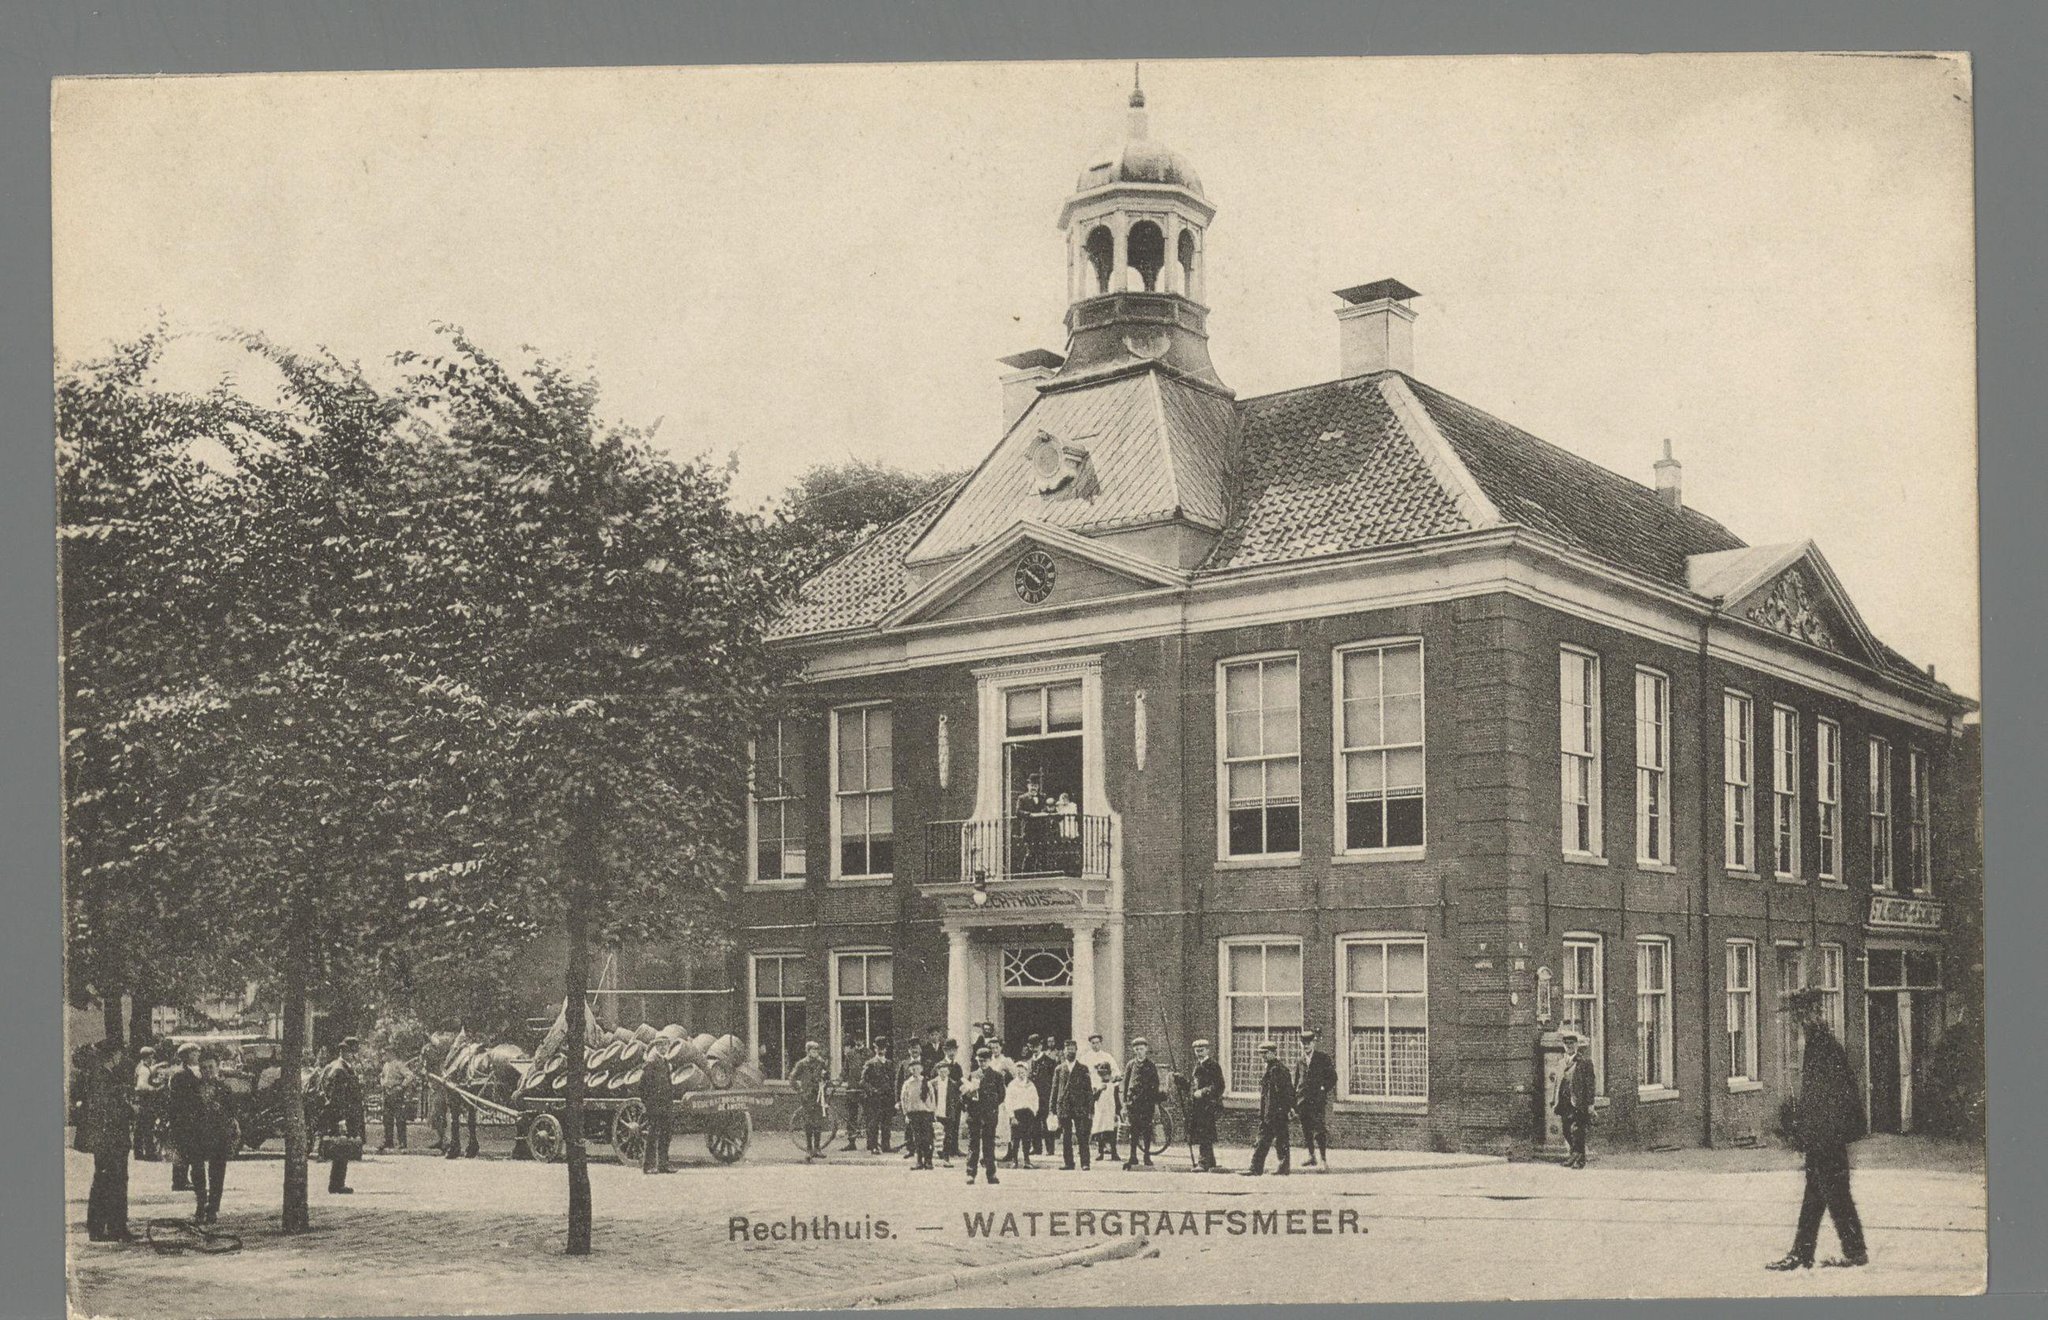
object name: photomechanical print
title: Rechthuis. Watergraafsmeer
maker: Anonymous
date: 1906-1921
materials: cardboard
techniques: photograph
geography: watergraafsmeer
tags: court building